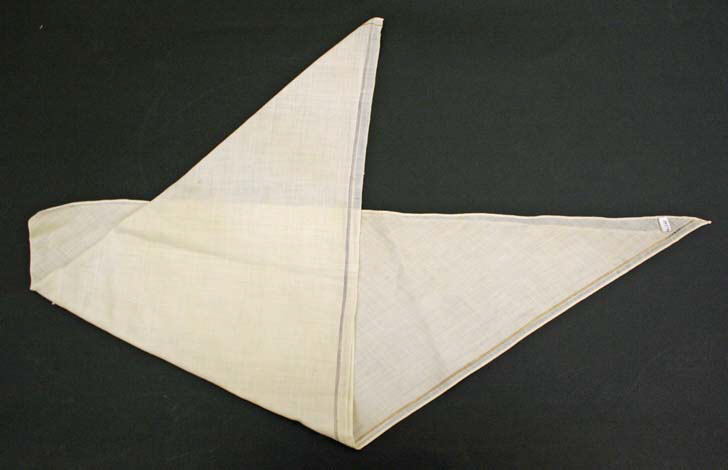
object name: fichu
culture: american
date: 1776-1800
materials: linen